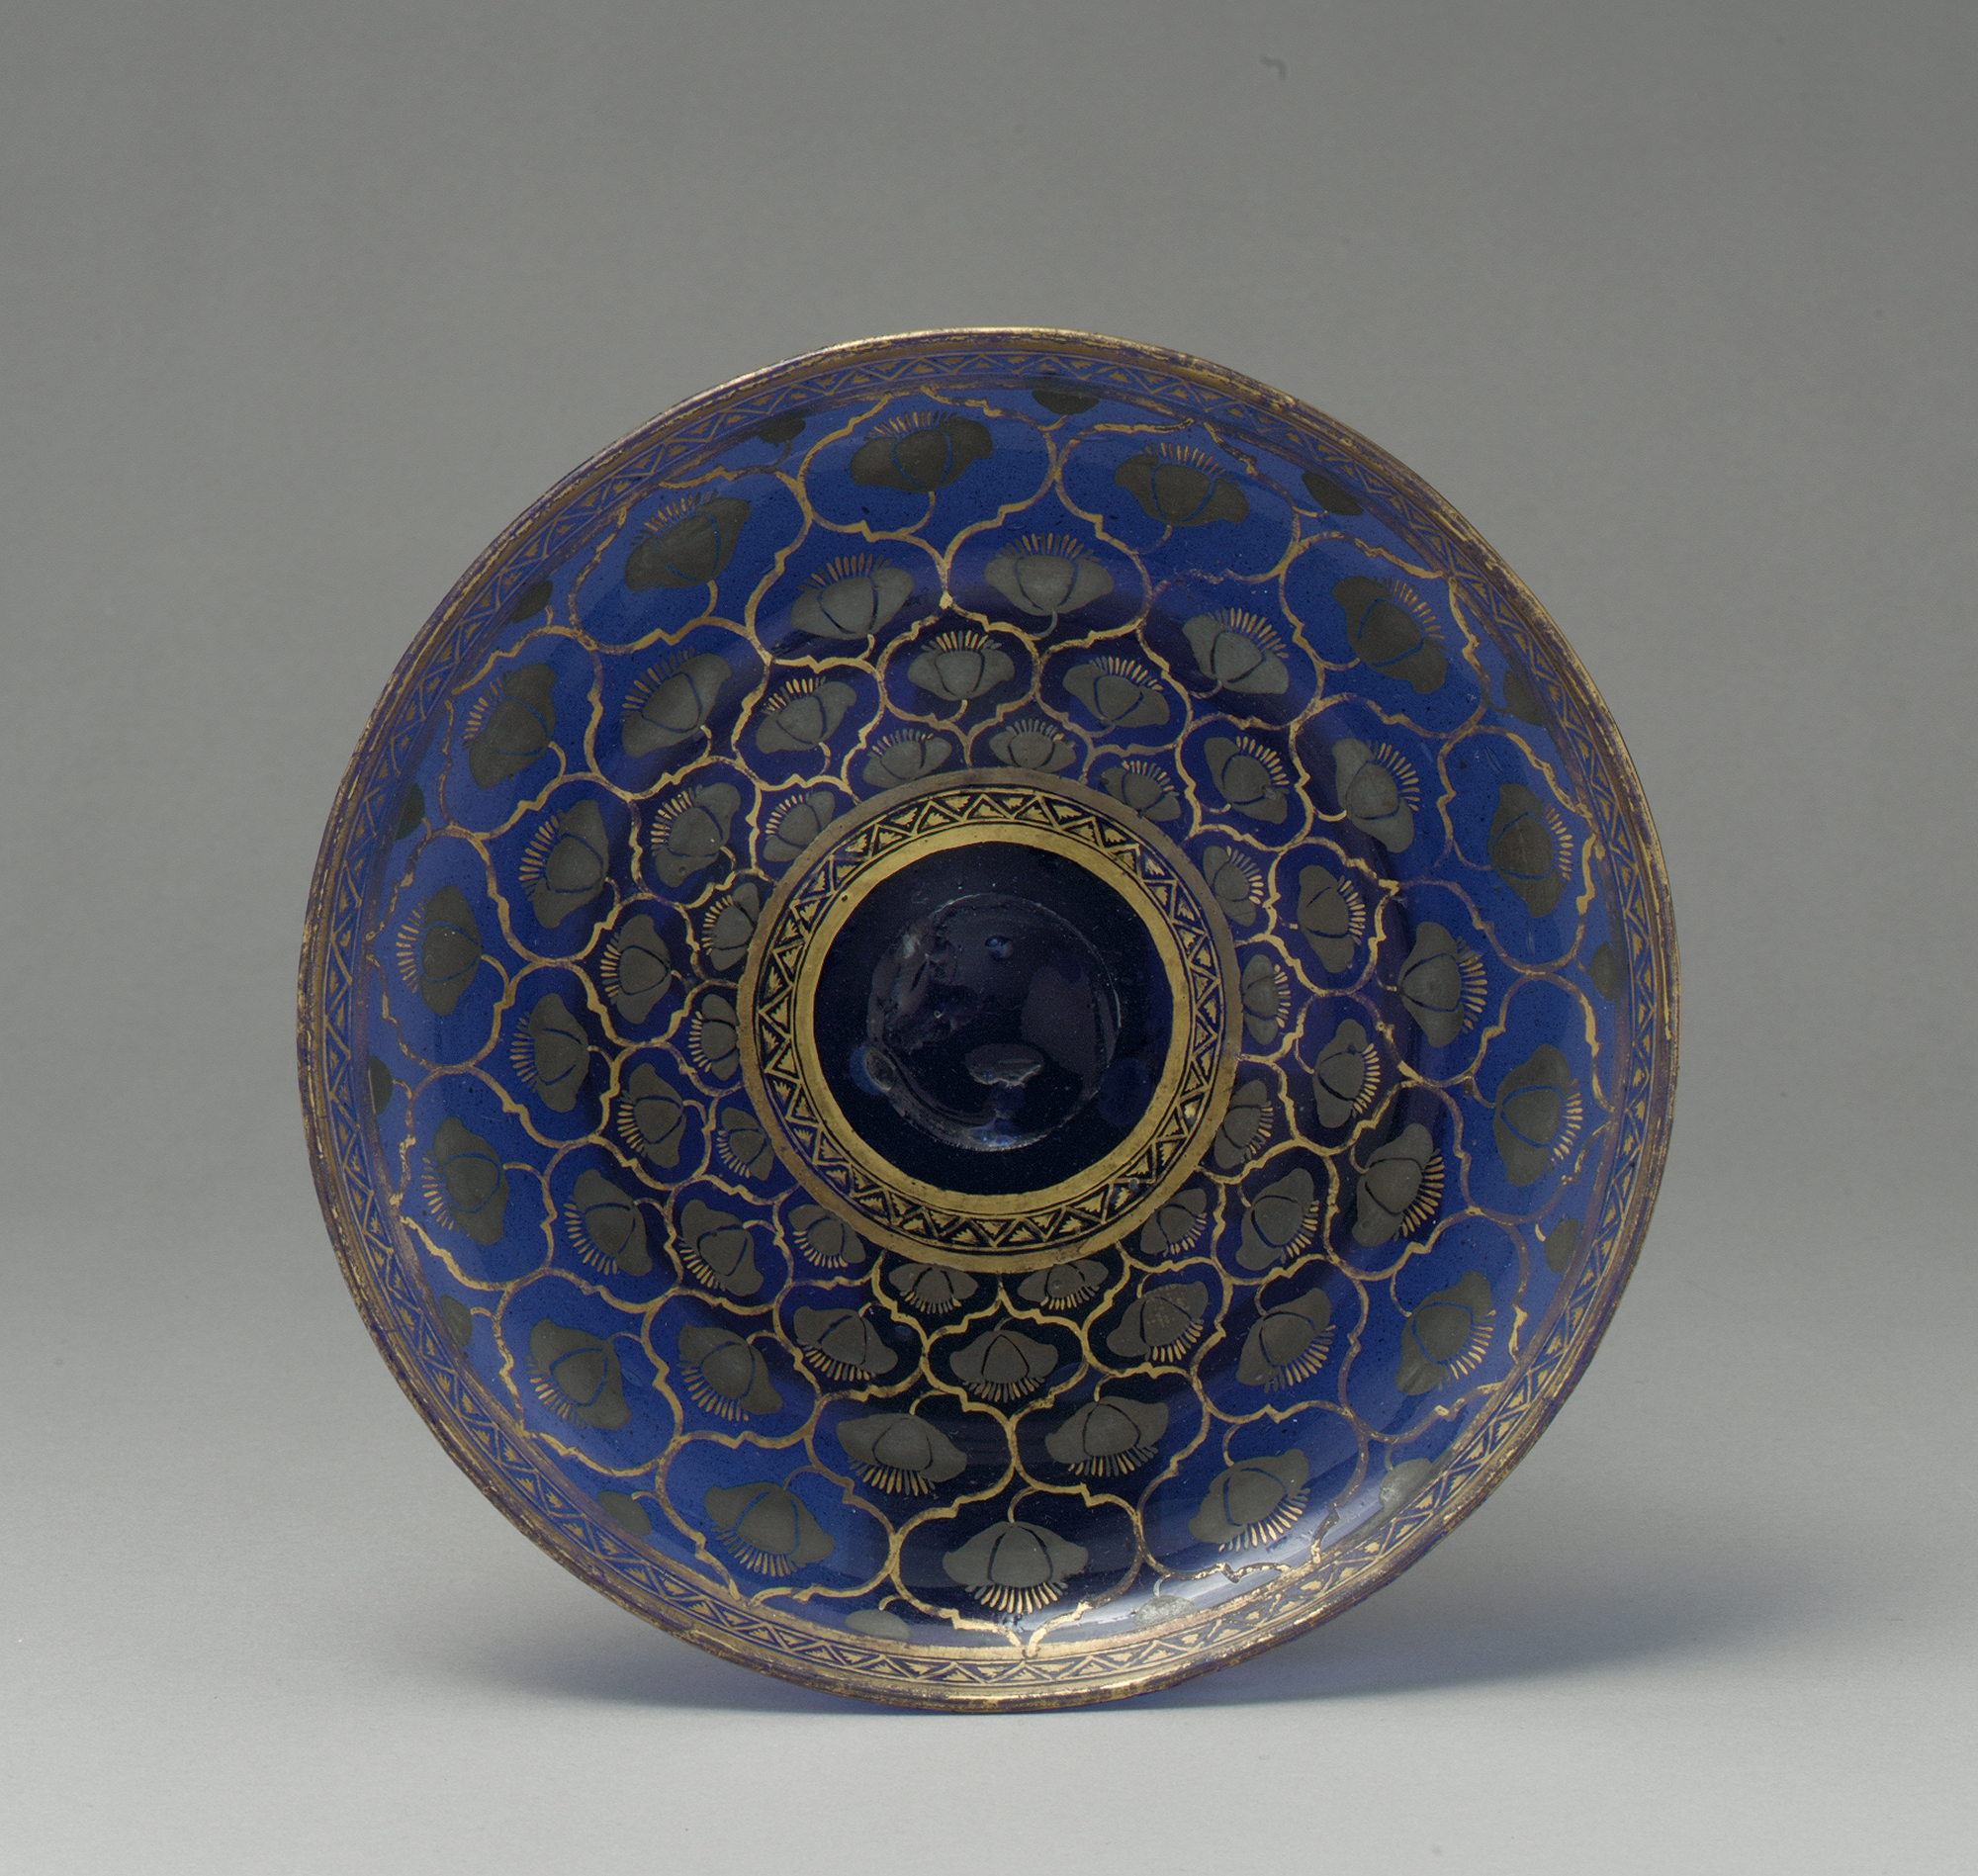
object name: dish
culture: indian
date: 1701-1800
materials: glass, gold, silver